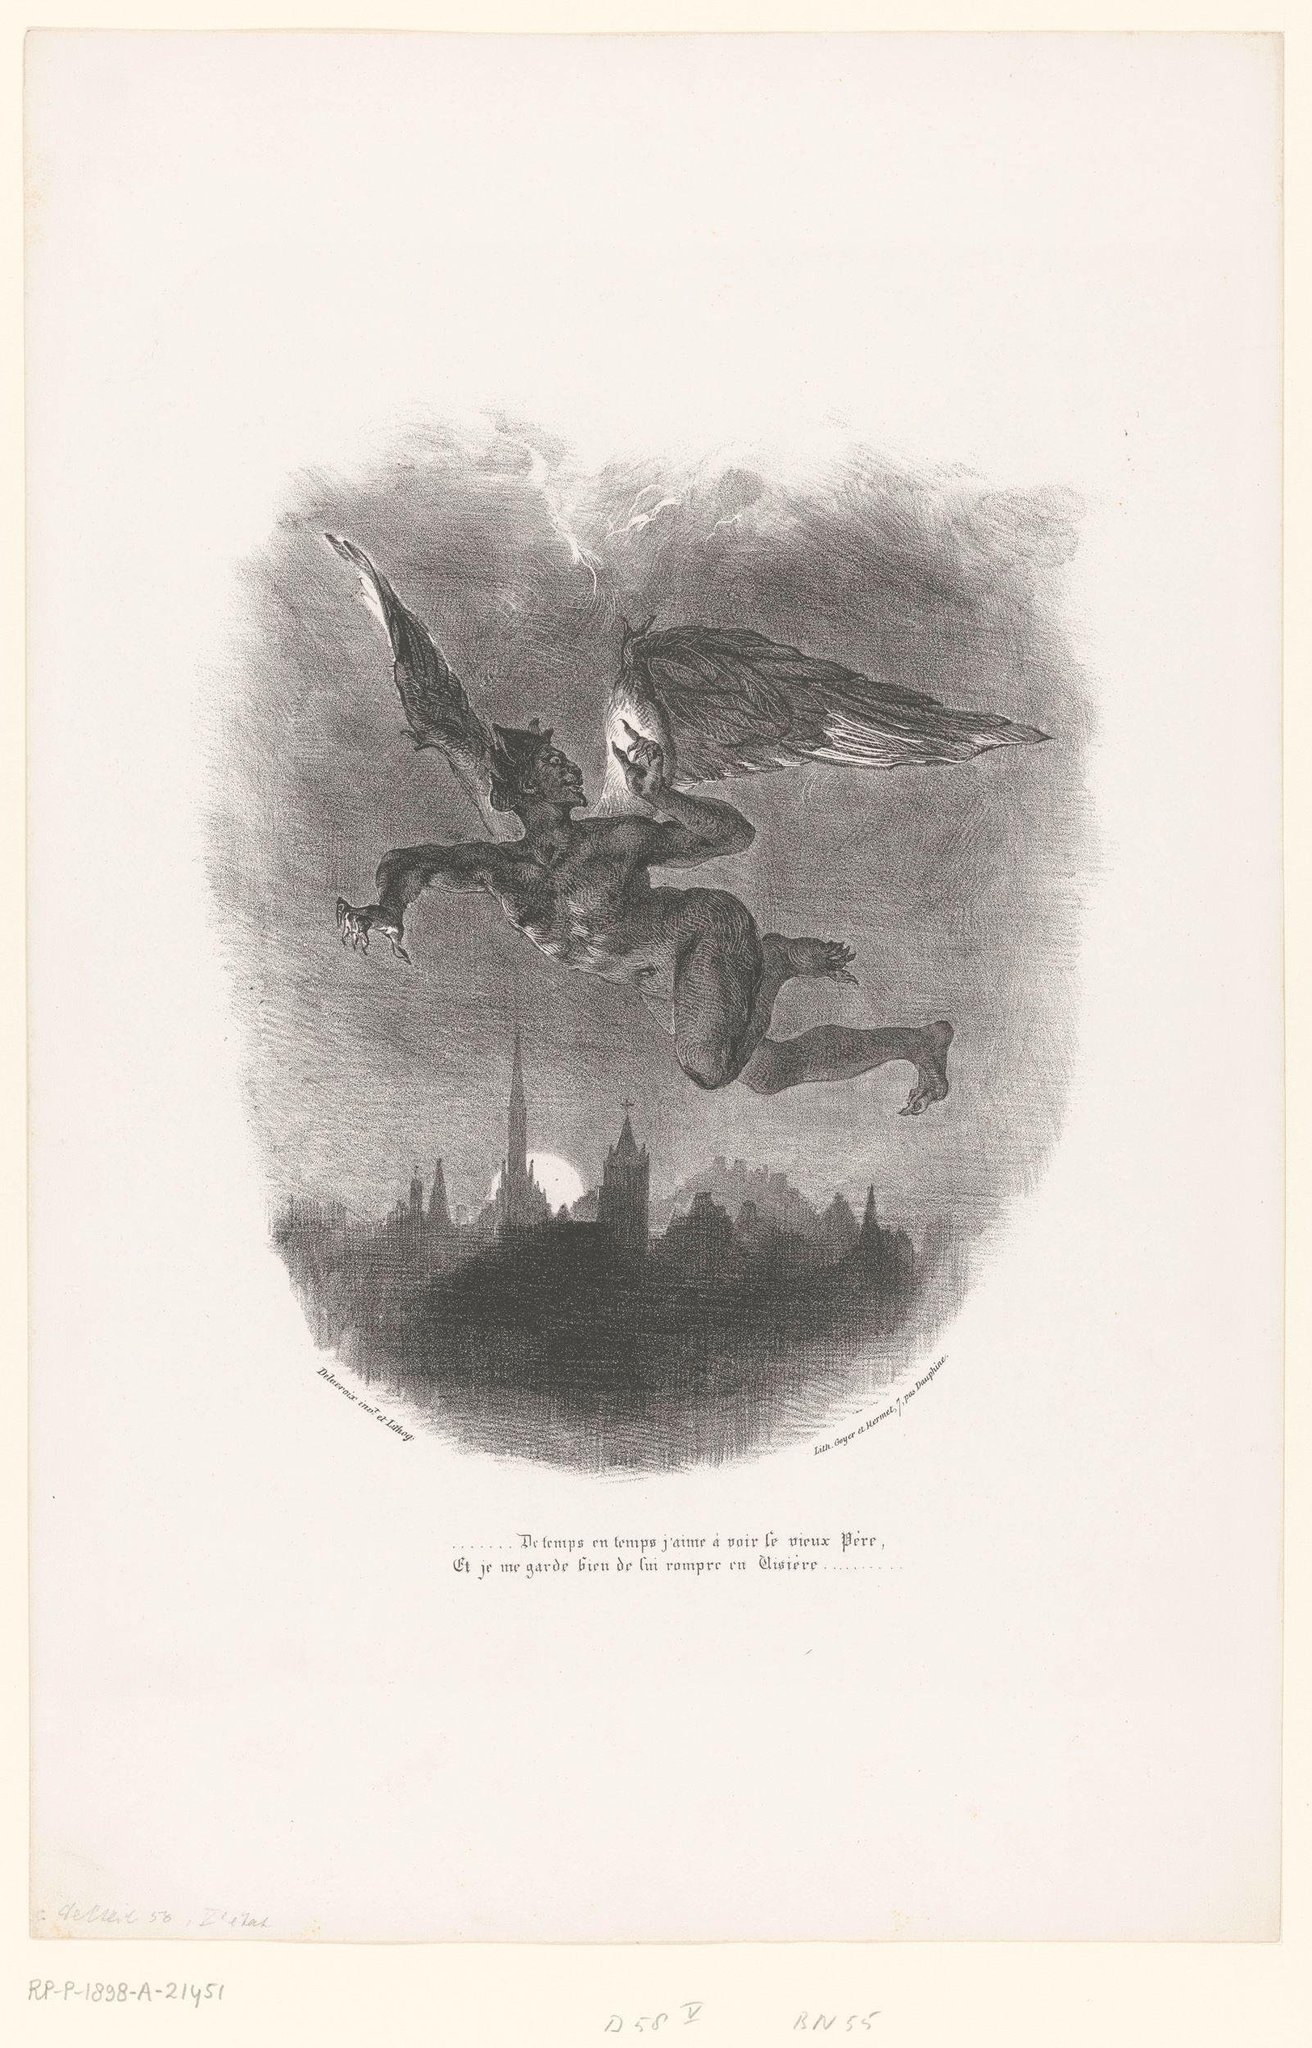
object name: print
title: De temps en temps j'aime à voir le vieux Père (...)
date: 1828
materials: paper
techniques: lithograph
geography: paris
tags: (scenes from) specific works of literature: goethe, faust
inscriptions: collector's mark: Lugt 2228a, collector's mark: Lugt 964